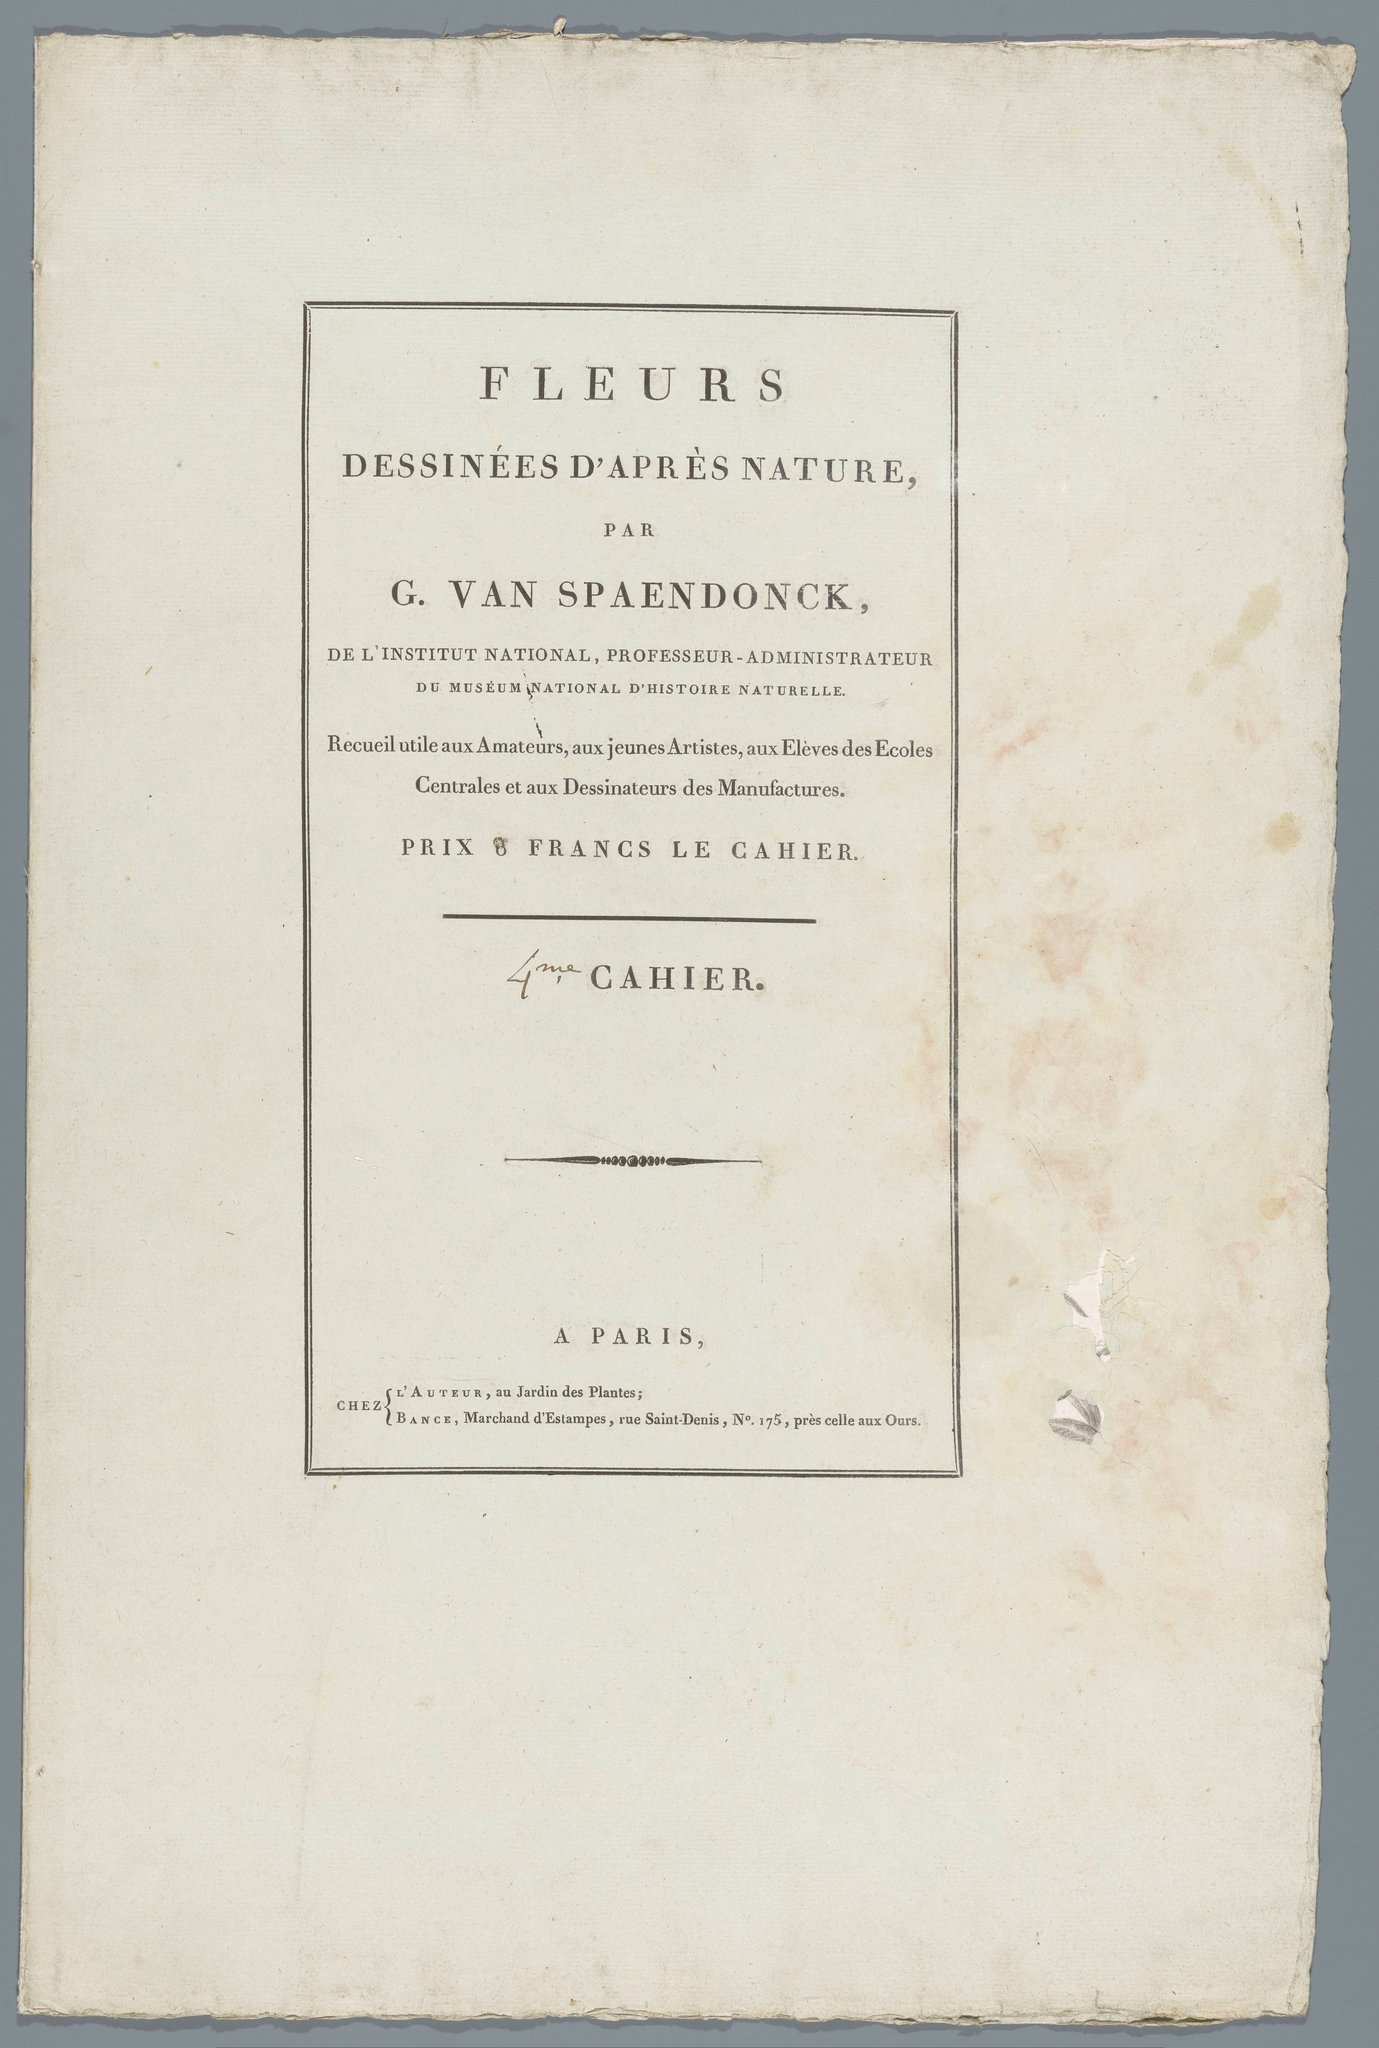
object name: print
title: Fleurs dessinées d'après nature (...) 4me Cahier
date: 1799-1801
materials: paper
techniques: letterpress printing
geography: paris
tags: book-cover, binding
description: De serie Fleurs dessinées d'après nature (...) bestaat uit 24 prenten verdeeld over zes omslagen. Het Rijksprentenkabinet heeft 23 prenten in zes omslagen in bezit. De verdeling over de omslagen lijkt willekeurig. Zie RP-P-1909-4220 t/m 4242 en RP-P-2016-53 t/m 58.